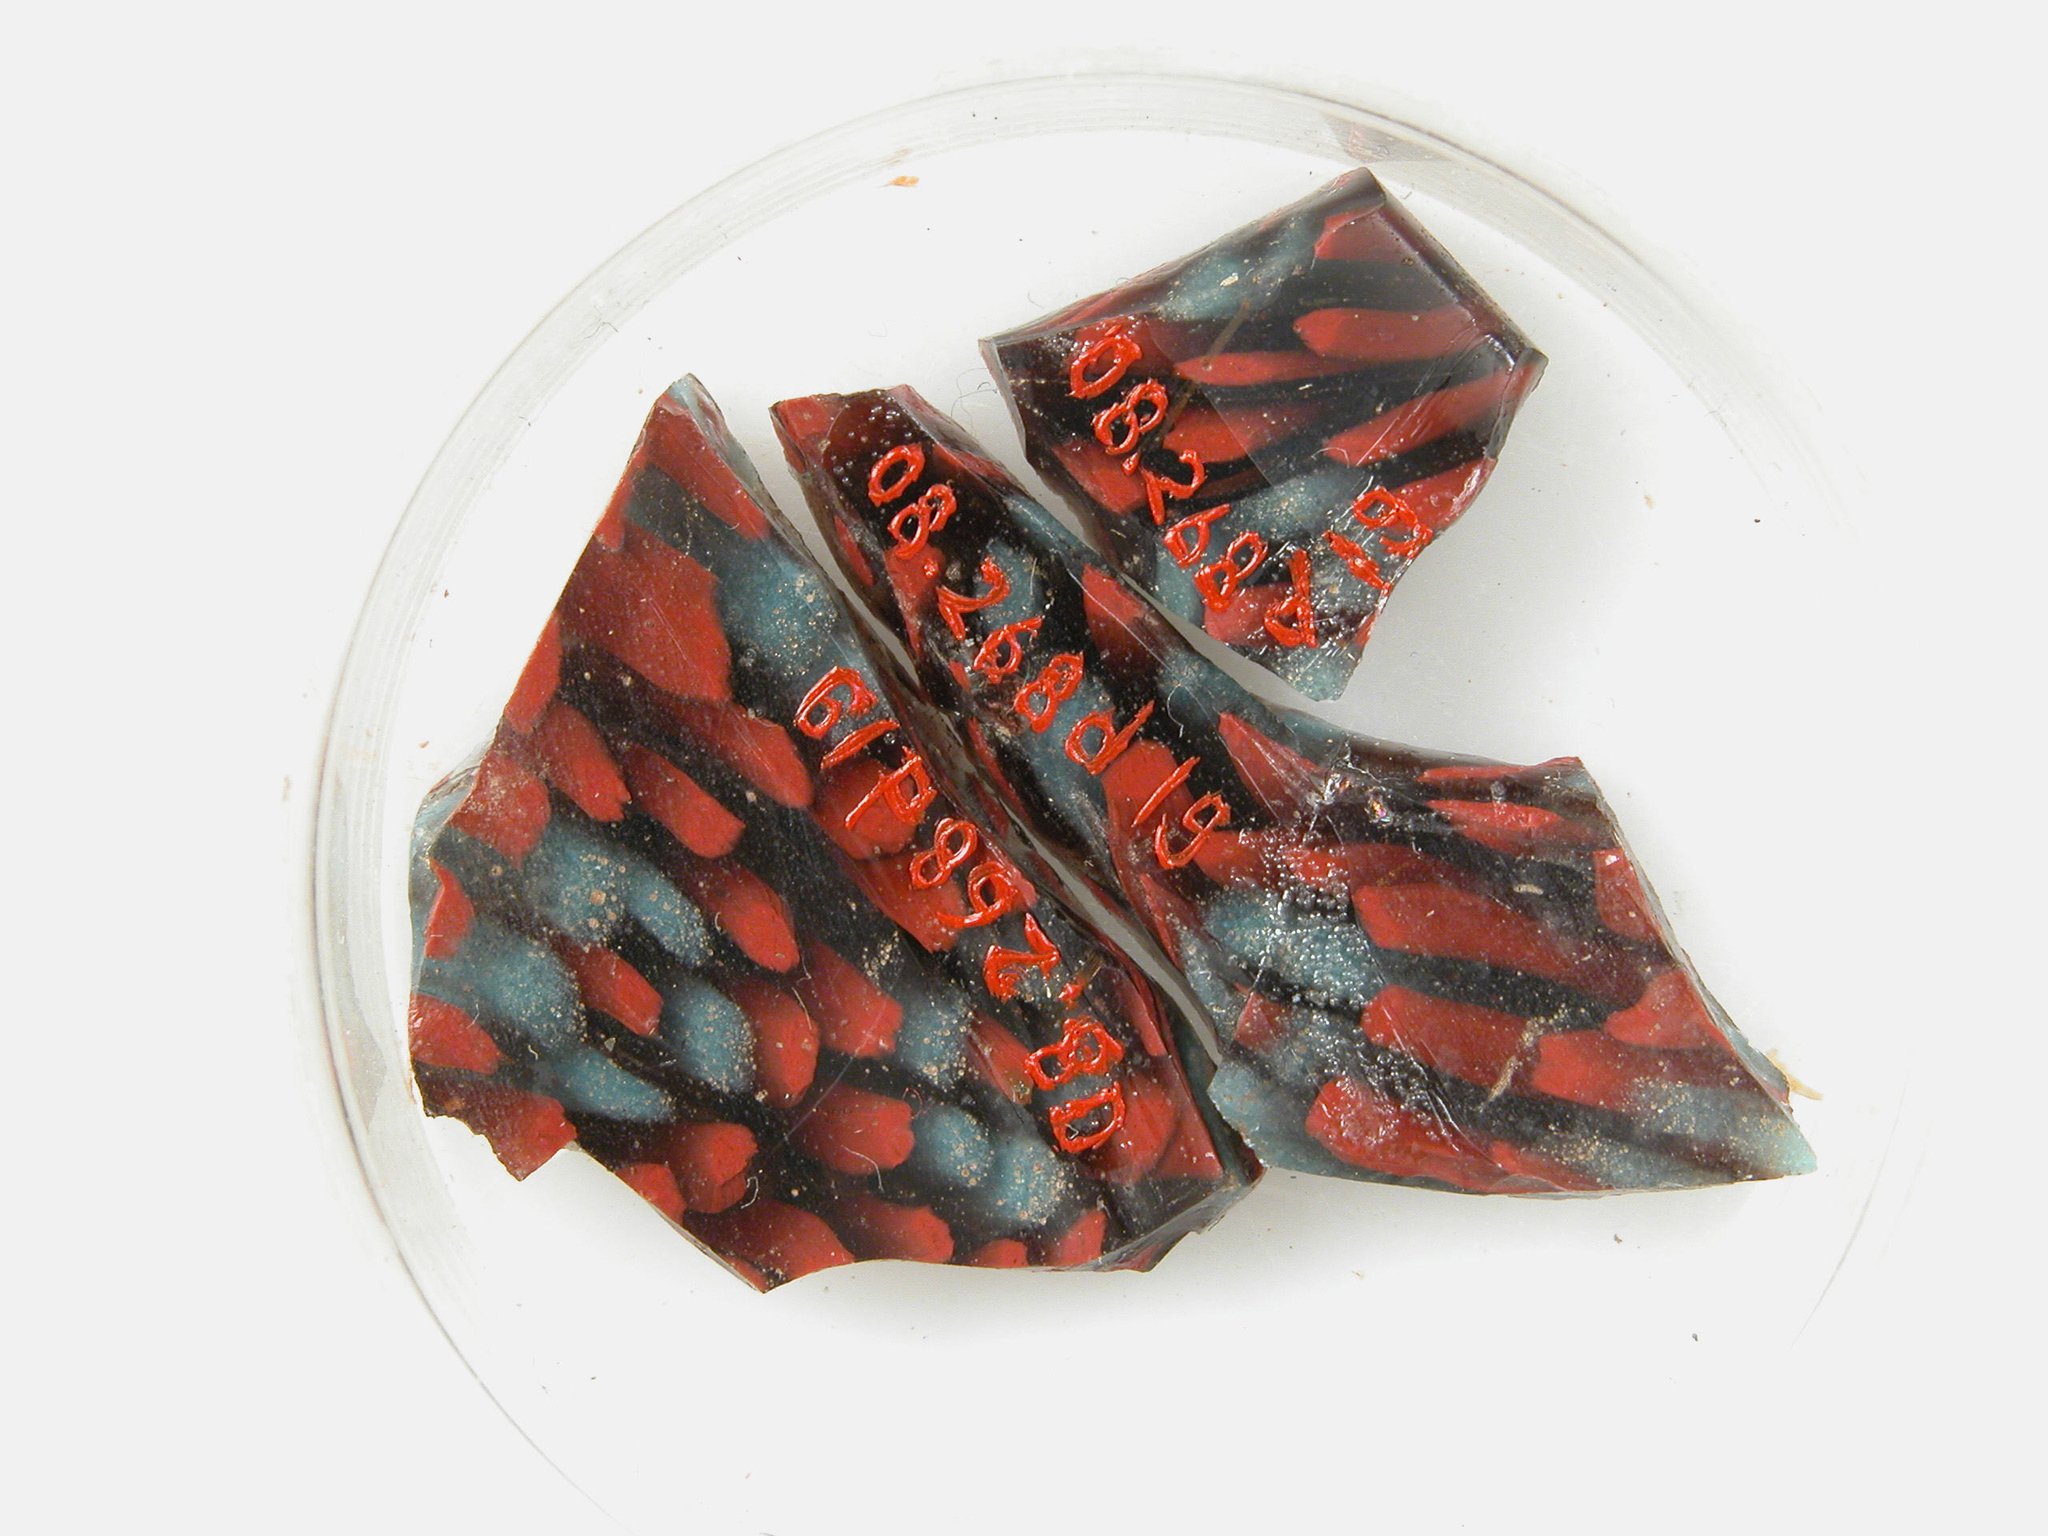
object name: fragment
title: Glass Fragments from a Vessel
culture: coptic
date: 301-433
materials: glass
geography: egypt